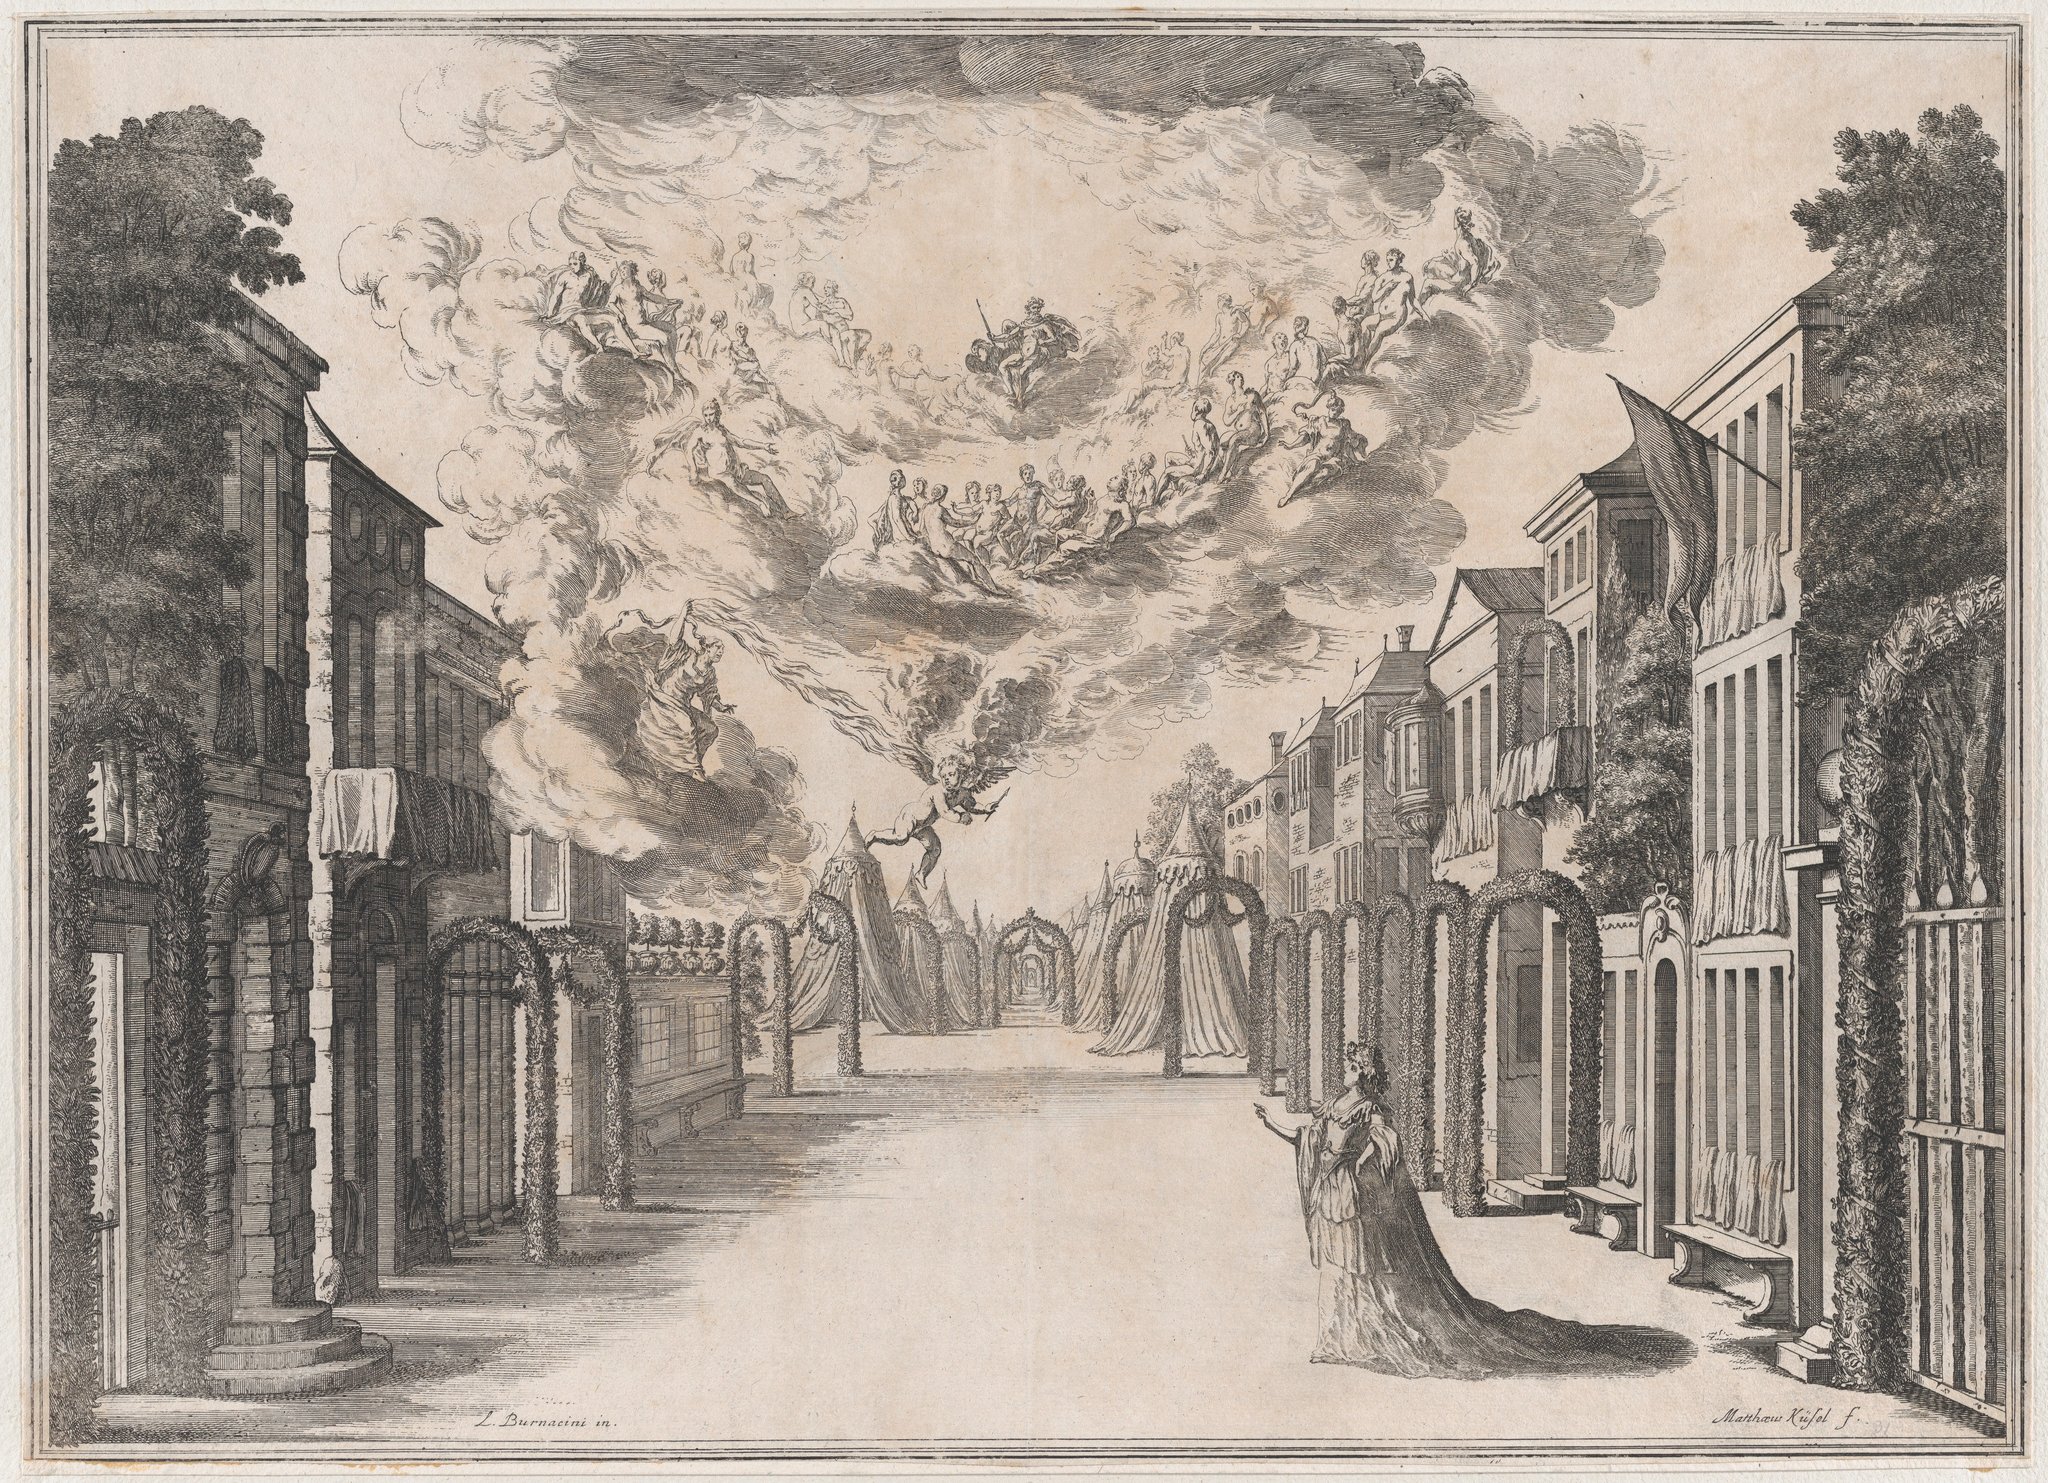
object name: print, fete, ornament architecture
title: A woman standing on an empty street, gazing up at the Olympian gods in the sky; set design from 'Il Fuoco Eterno'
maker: mathäus küsel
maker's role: artist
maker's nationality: german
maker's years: 1621-1682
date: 1674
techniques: etching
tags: buildings,streets,women,goddess